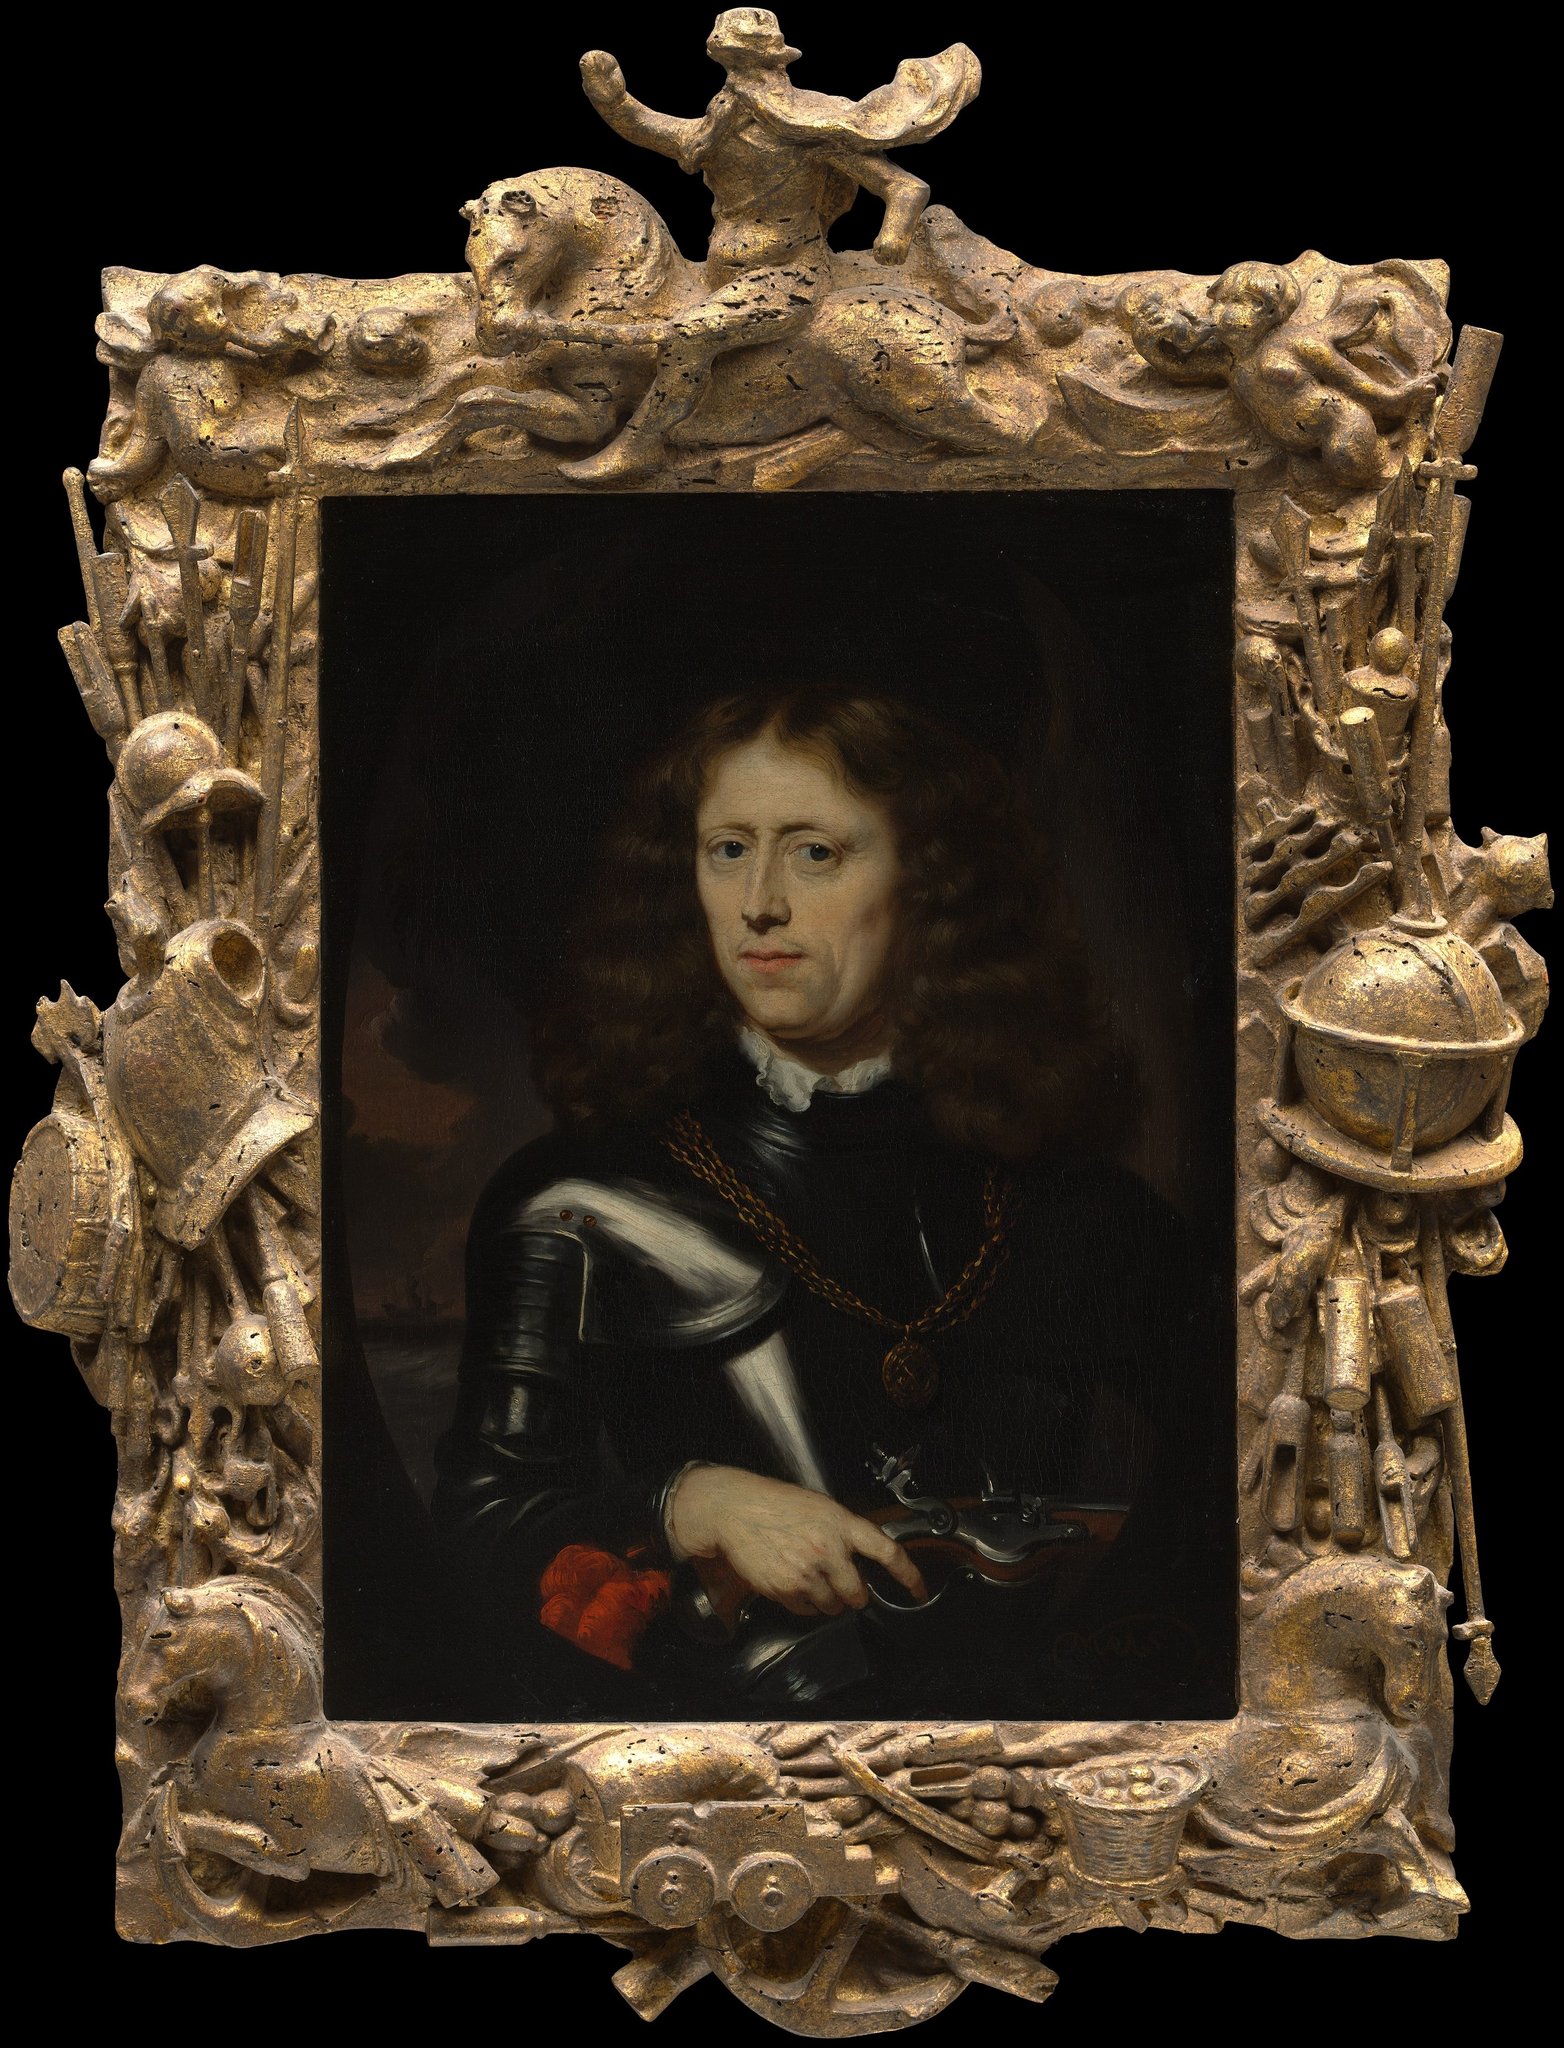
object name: painting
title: Admiral Jacob Binkes (born about 1640, died 1677)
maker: nicolaes maes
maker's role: artist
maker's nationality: dutch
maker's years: 1634-1693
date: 1654-1693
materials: canvas, oil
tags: men,portraits